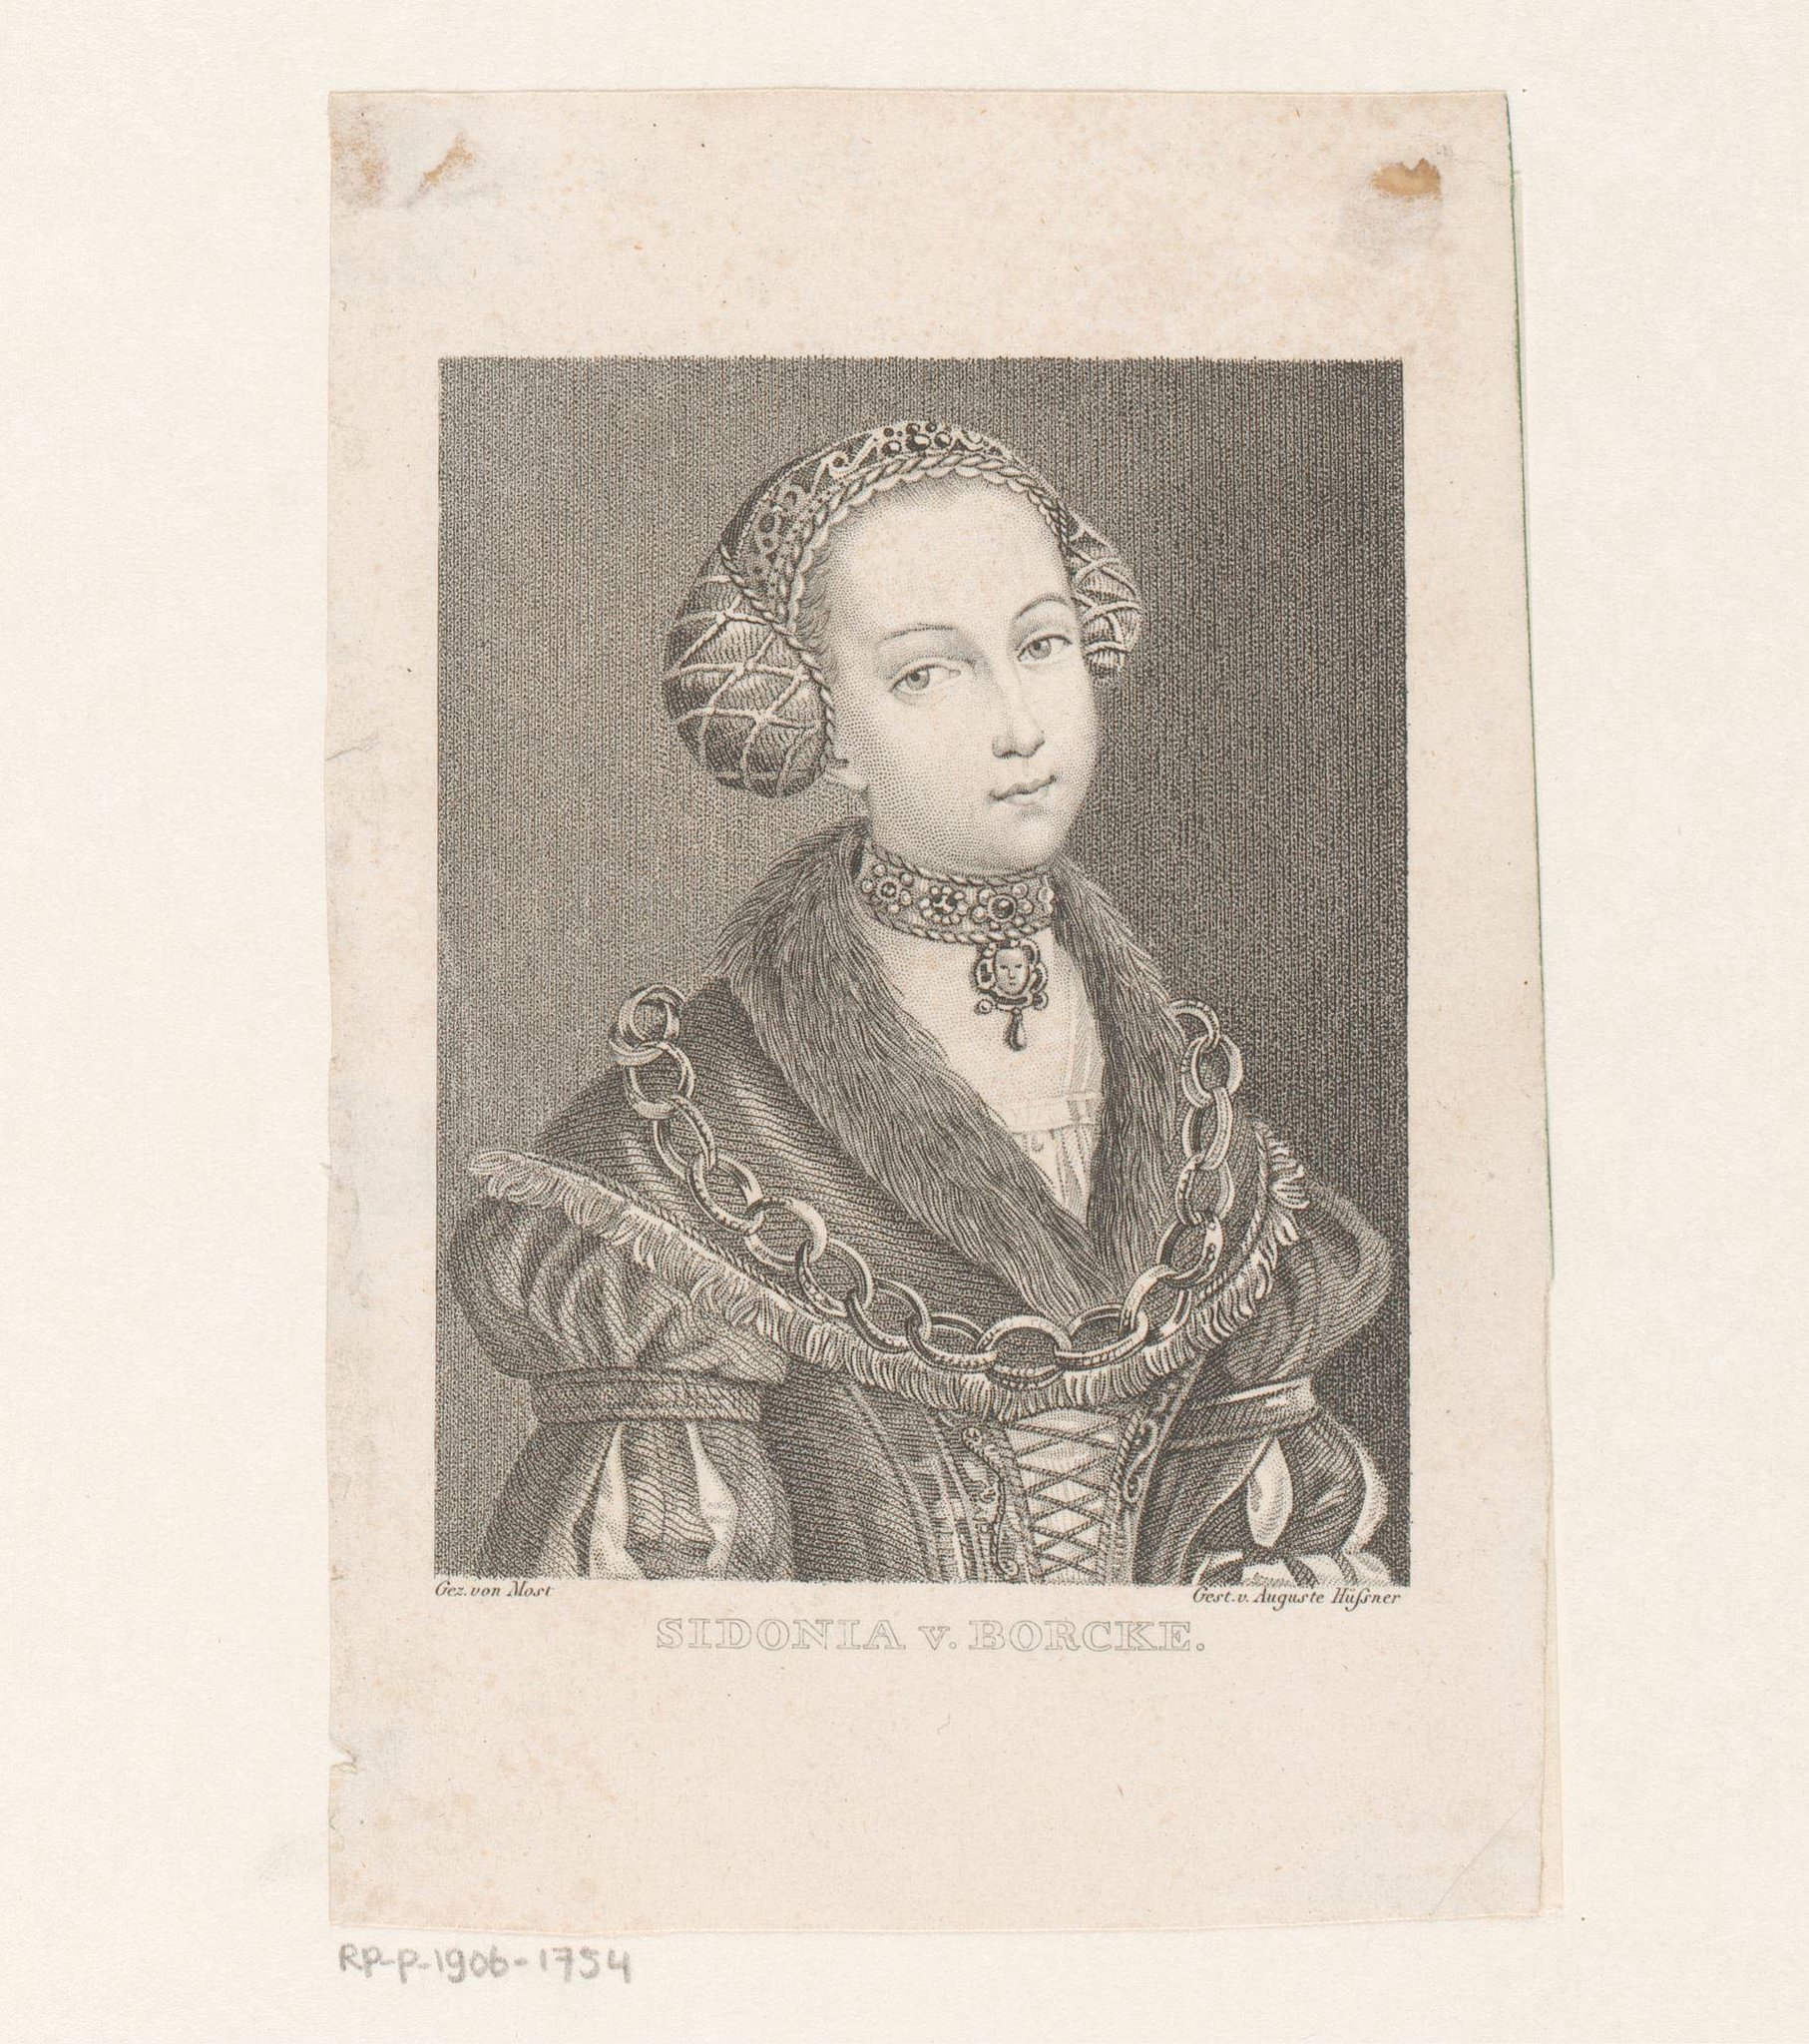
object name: print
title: Portret van Sidonia von Borcke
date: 1799-1877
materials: paper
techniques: etching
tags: nun(s), historical persons, ornaments, jewels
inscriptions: collector's mark: Lugt 2228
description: Deze prent is gemaakt naar (een tekening van) een schilderij door een onbekende kunstenaar getiteld 'Portret Sydonii Borek' uit 1610, wat zich in de collectie van het National Museum in Szczecin bevindt.